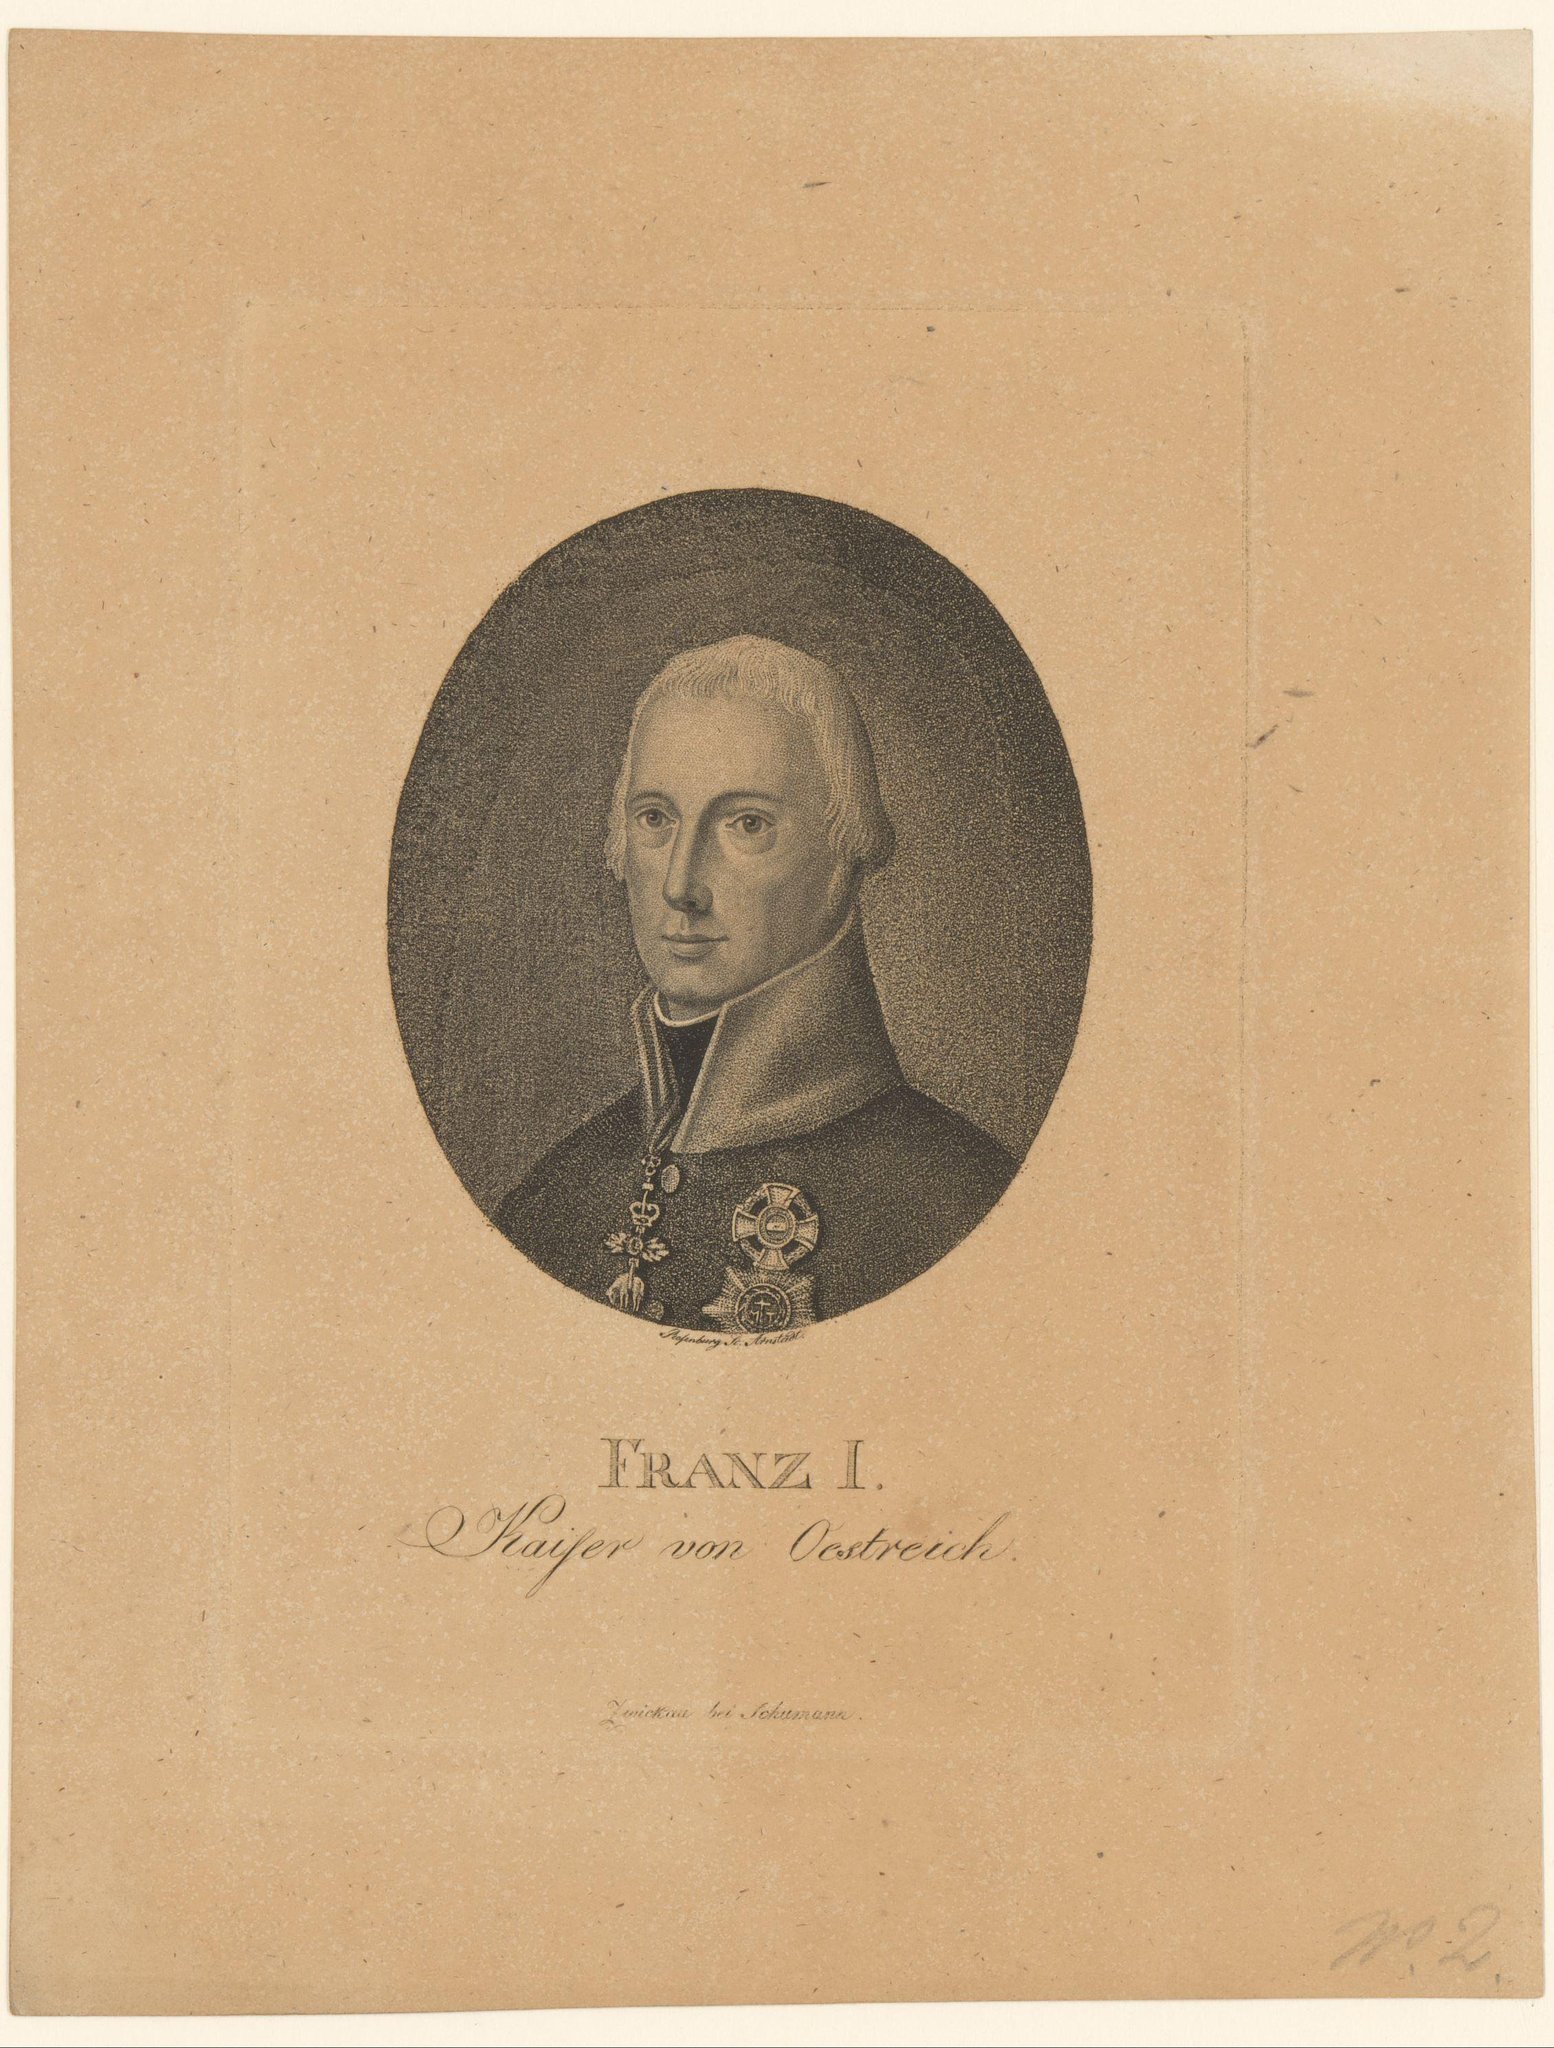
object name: print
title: Portret van Frans II Josef Karel, Rooms-Duits keizer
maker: rosenburg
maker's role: print maker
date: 1804-1849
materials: paper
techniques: engraving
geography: zwickau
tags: frans ii (rooms-duits keizer), historical persons, medals and other marks of military honour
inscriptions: collector's mark: Lugt 2228